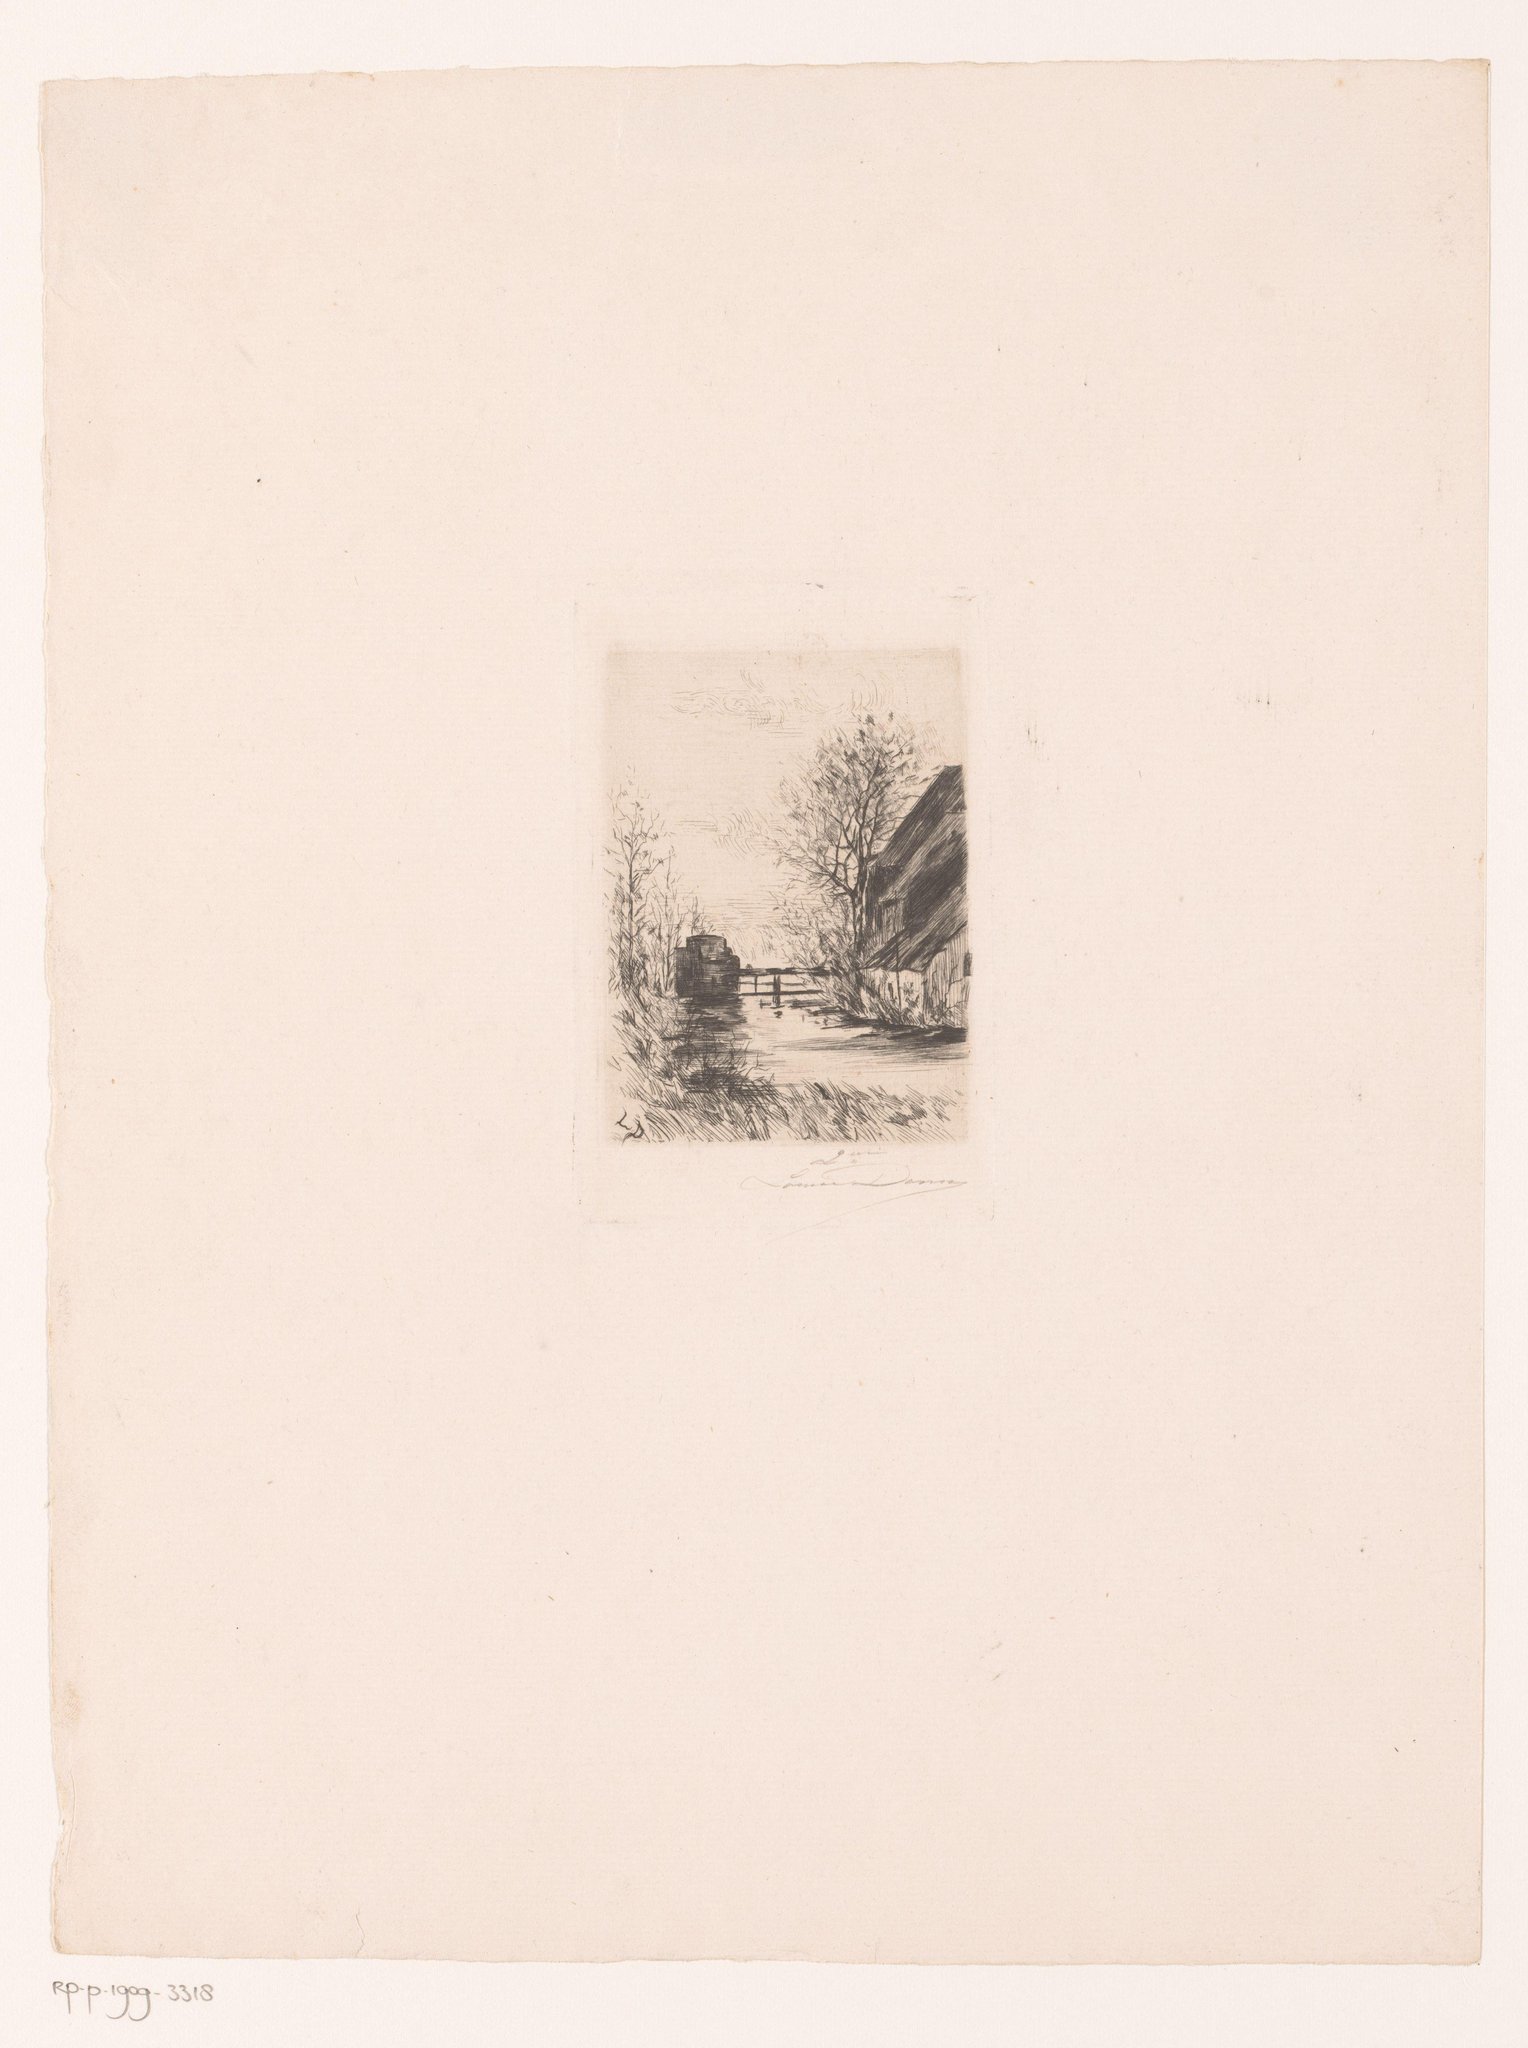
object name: print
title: Boerderij bij een brug over een brede sloot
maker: louise danse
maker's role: painter, print maker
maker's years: 1867-1948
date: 1877-1909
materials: paper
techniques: drypoint, etching, intaglio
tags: landscape with bridge, viaduct or aqueduct, farm or solitary house in landscape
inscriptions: annotation: ‘2ème’